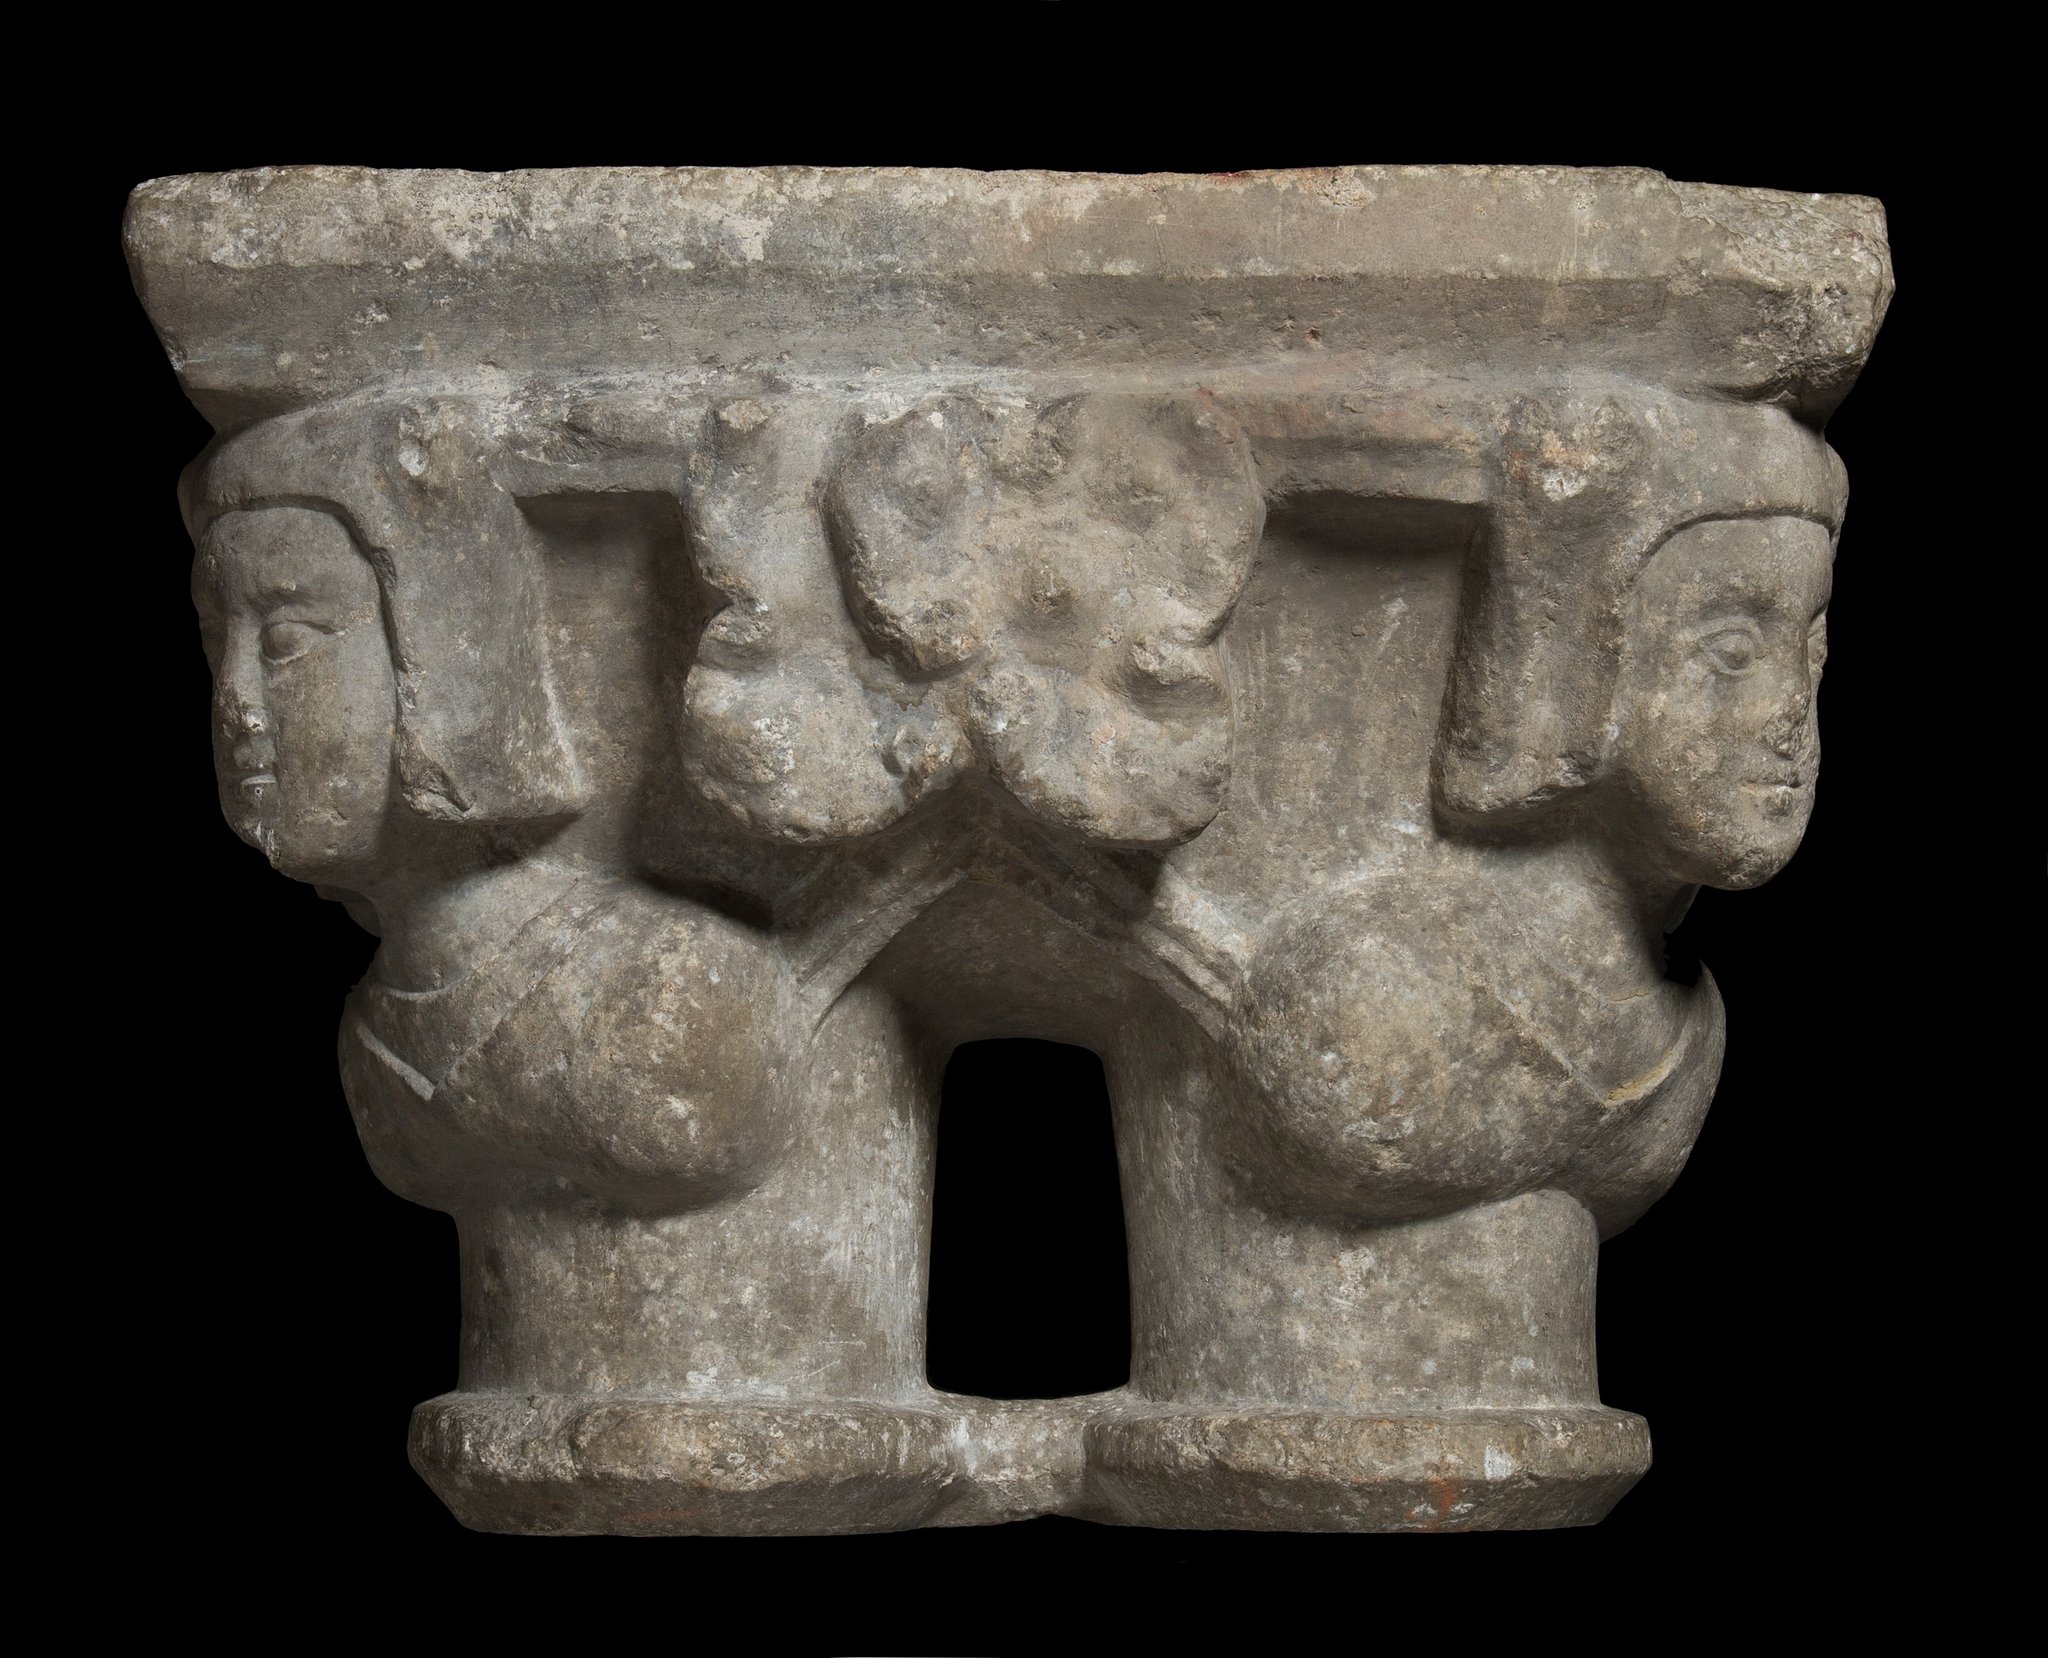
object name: capital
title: Double Capital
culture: french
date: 1201-1400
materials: limestone, stone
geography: france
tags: heads